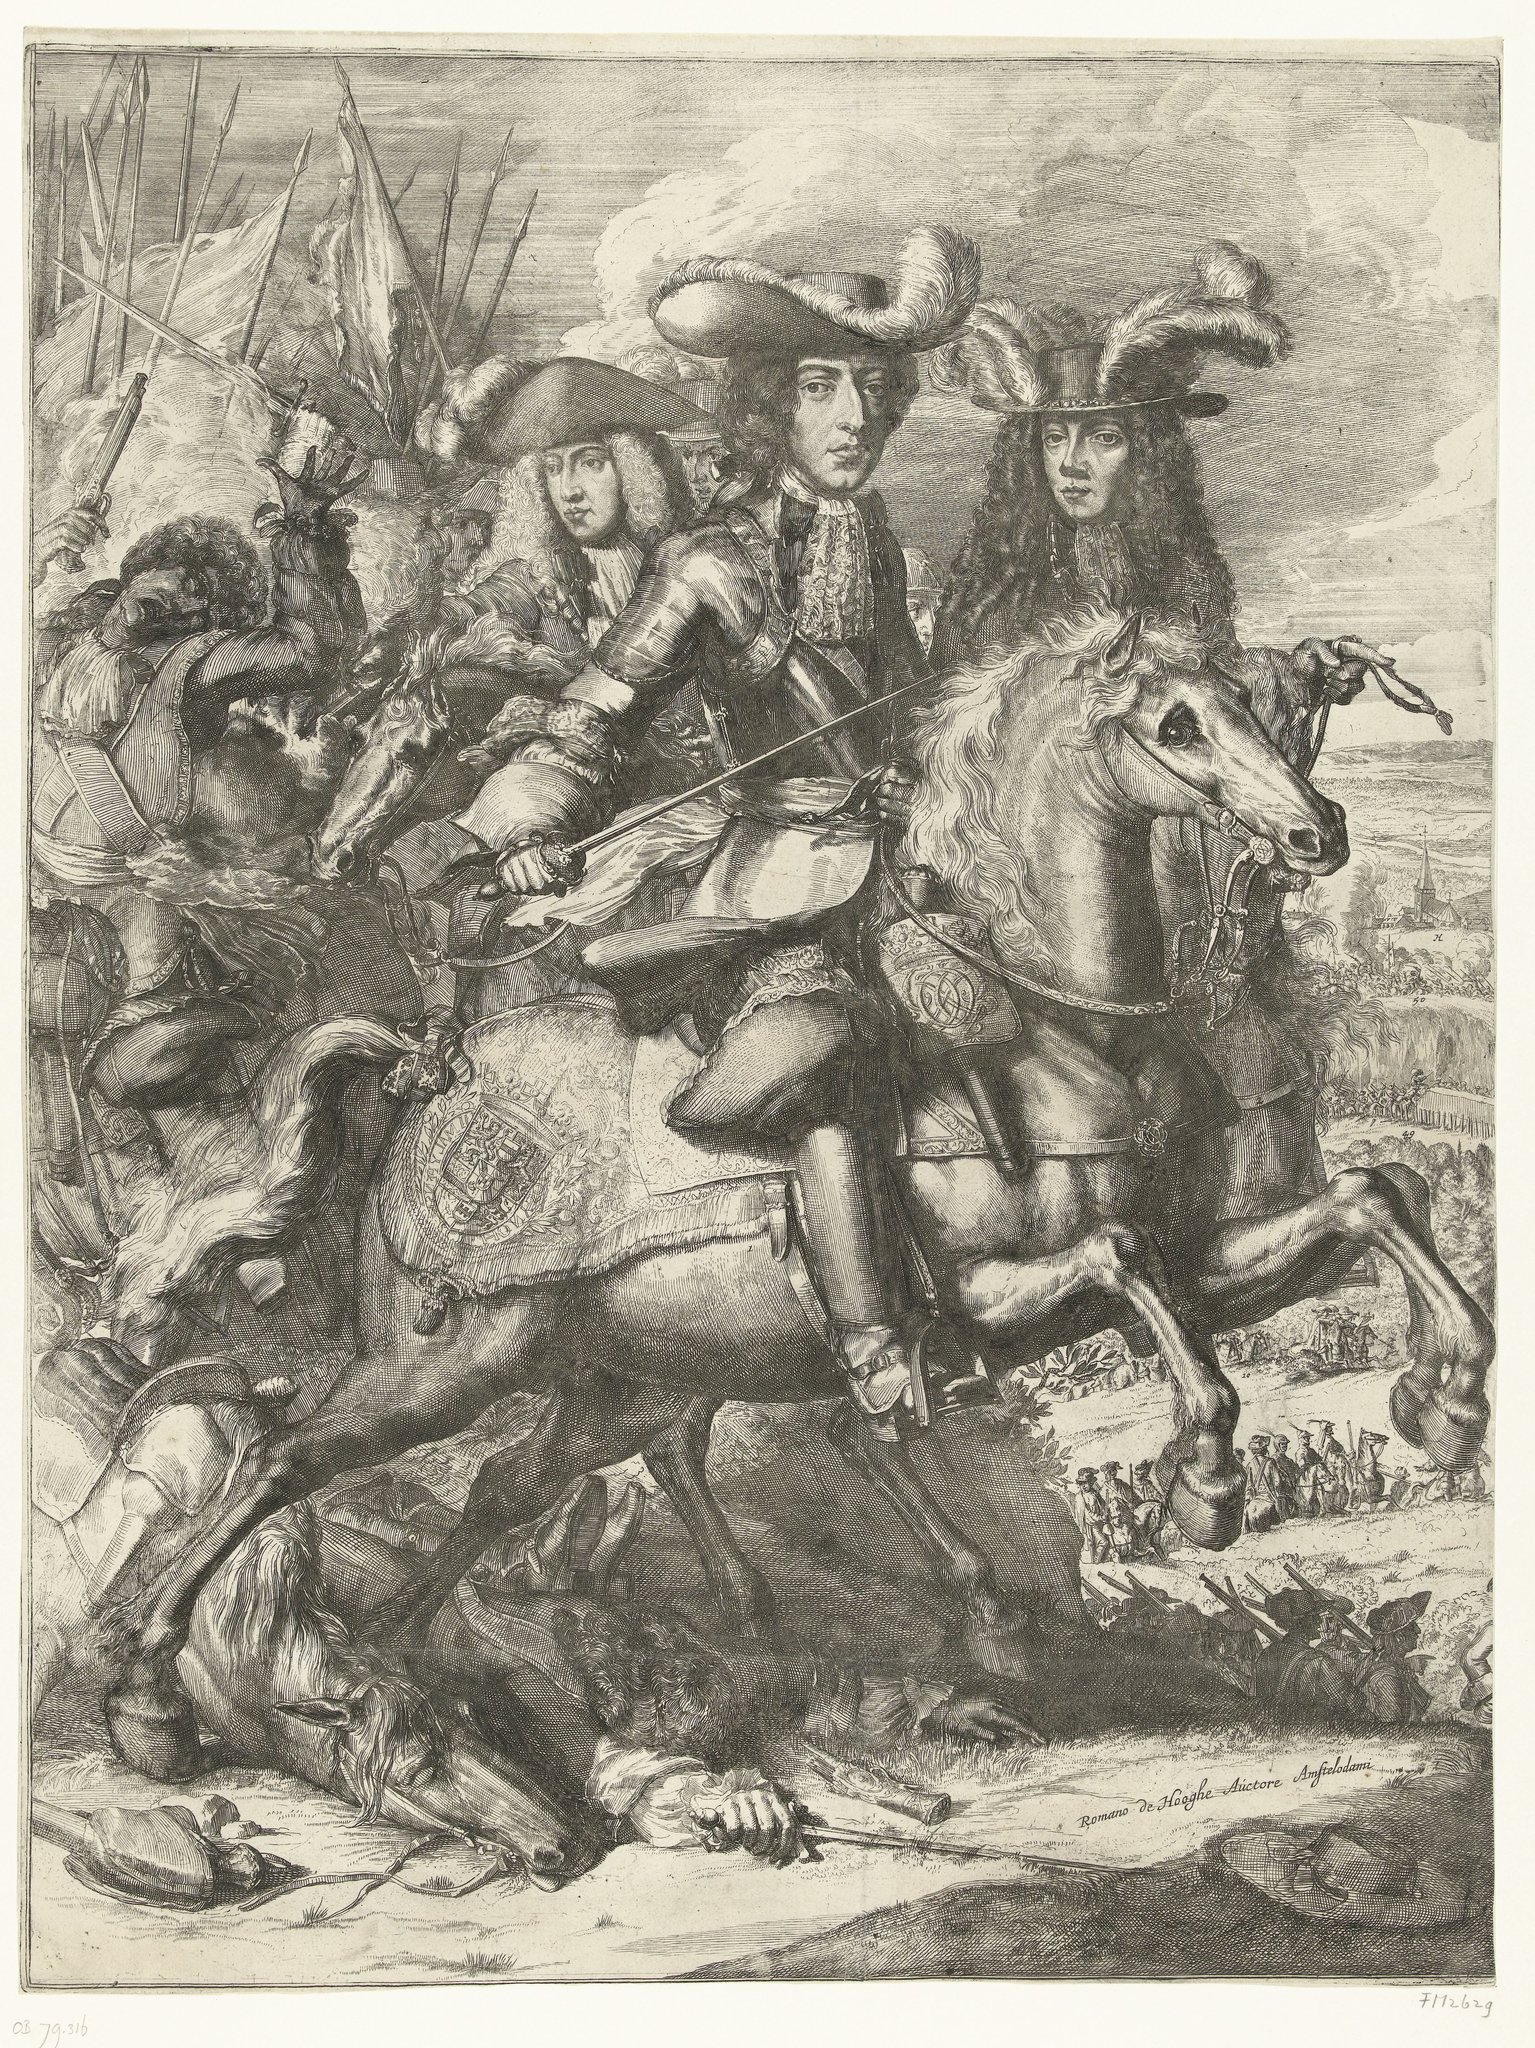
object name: print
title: Slag bij St. Denis (linkerhelft), 1678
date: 1678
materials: paper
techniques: etching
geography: amsterdam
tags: william iii (prince of orange and king of england, scotland, and ireland), carlos de aragón de gurrea (9th duke of villahermosa), london, equestrian state-portrait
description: Grote voorstelling van slag bij St. Denis op 14 augustus 1678, op twee bladen, linker blad. Prins Willem III naast de hertog van Monmouth te paard met andere leden van zijn generale staf.